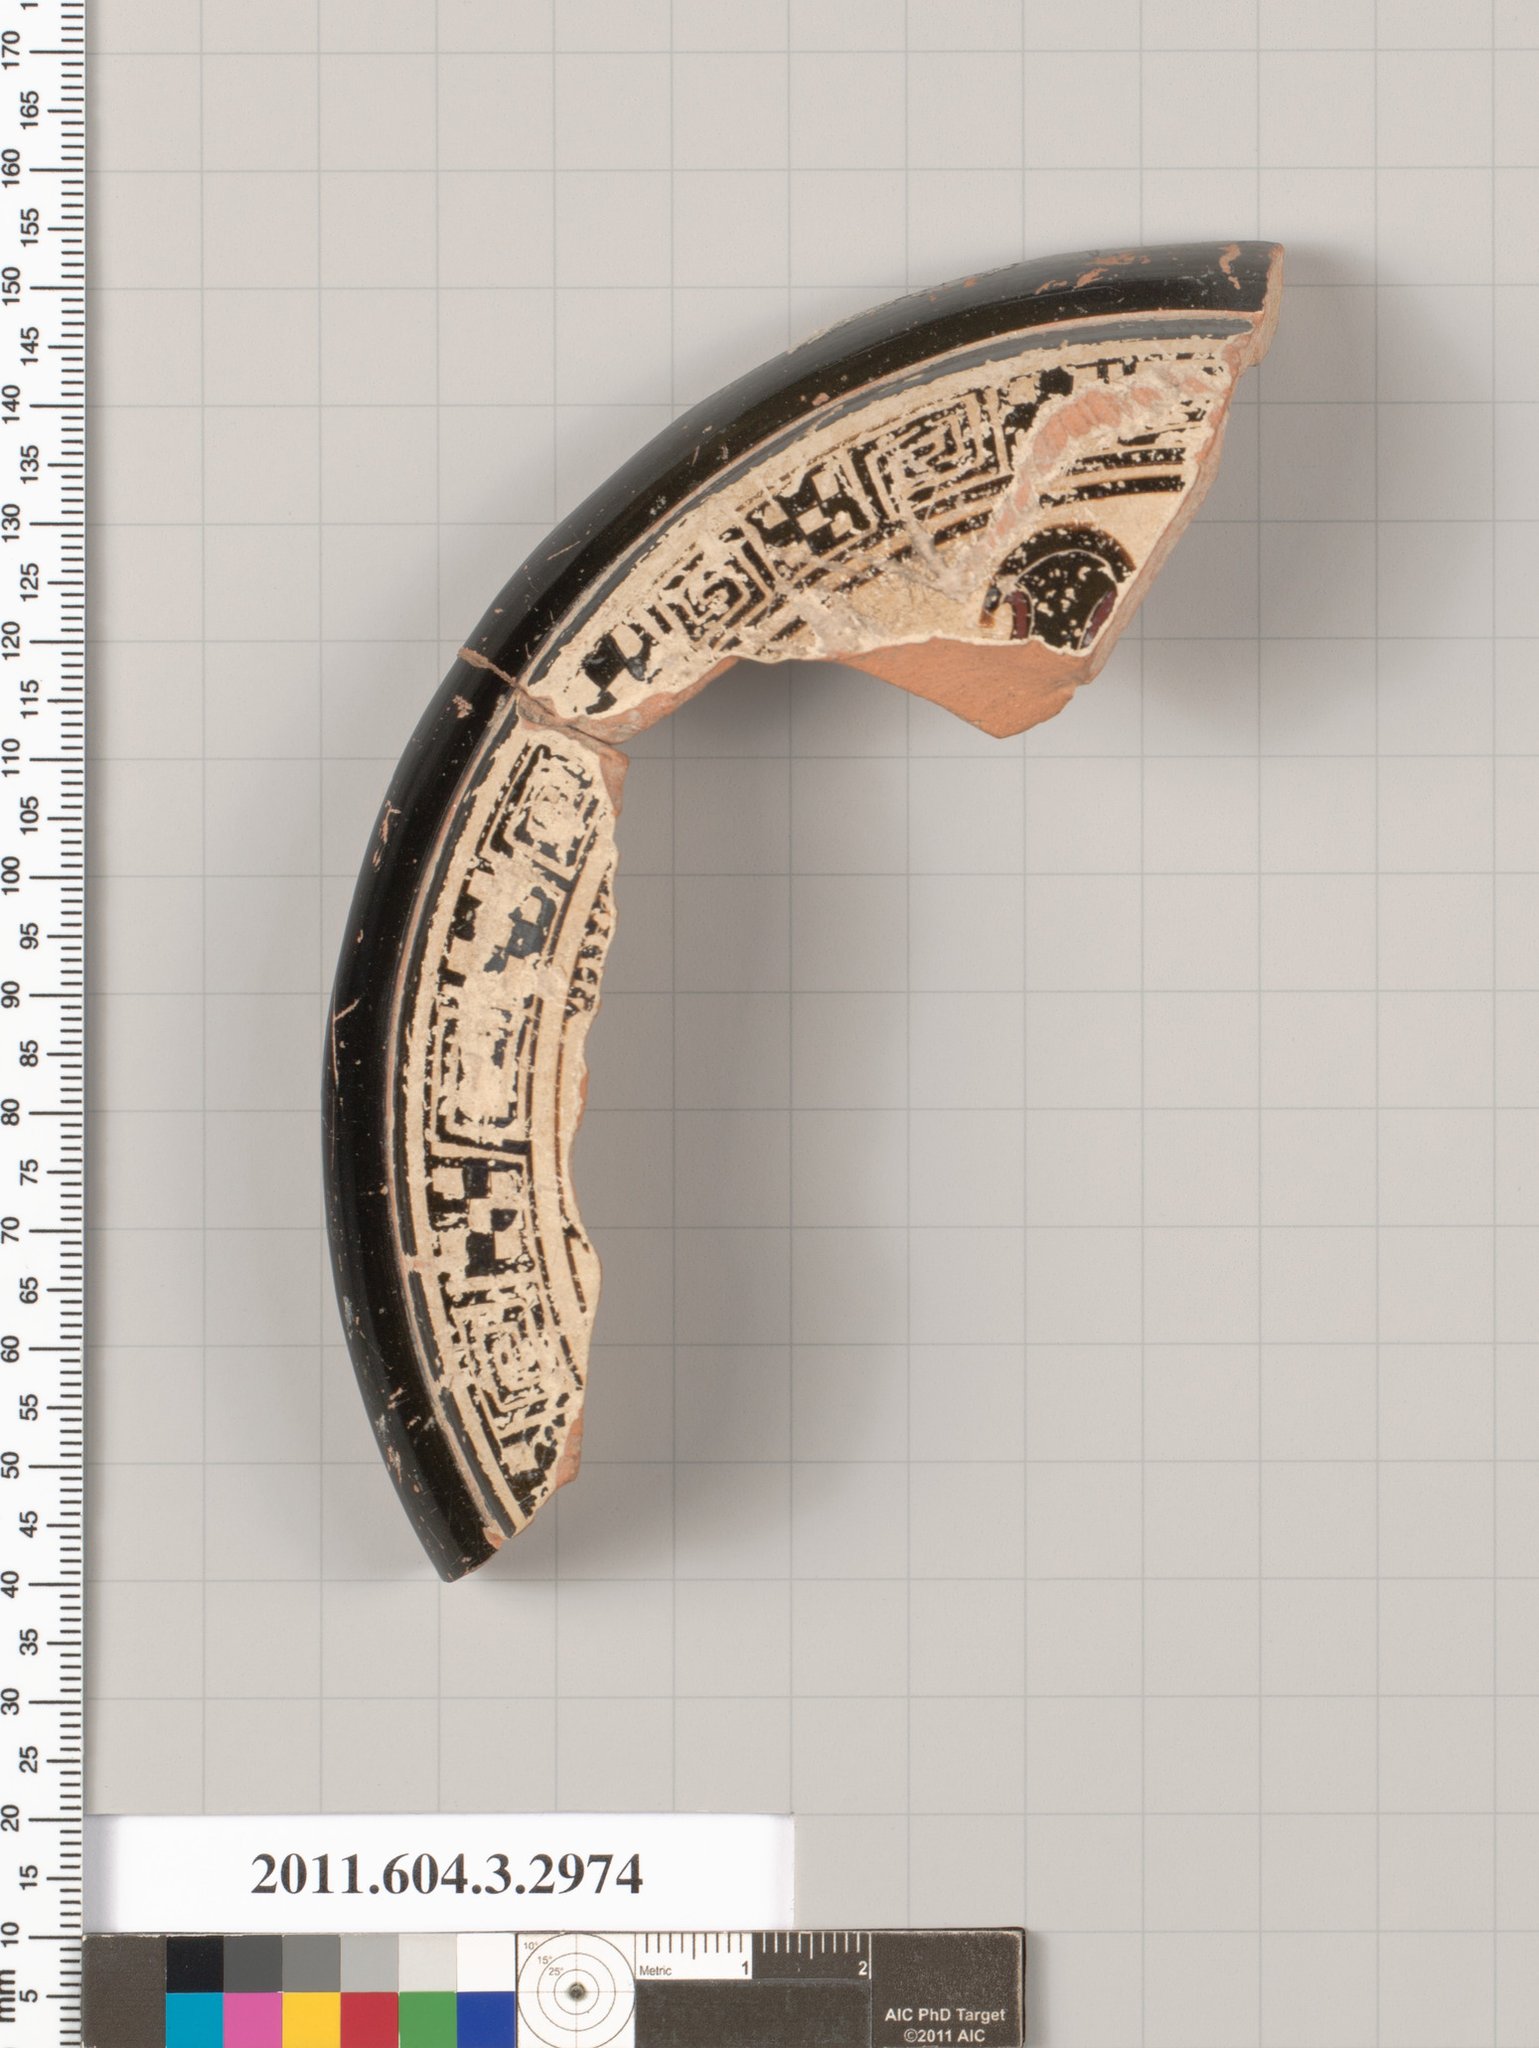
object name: pyxis fragment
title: Terracotta fragment of a pyxis (box)?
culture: greek, attic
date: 490-480 BCE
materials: terracotta